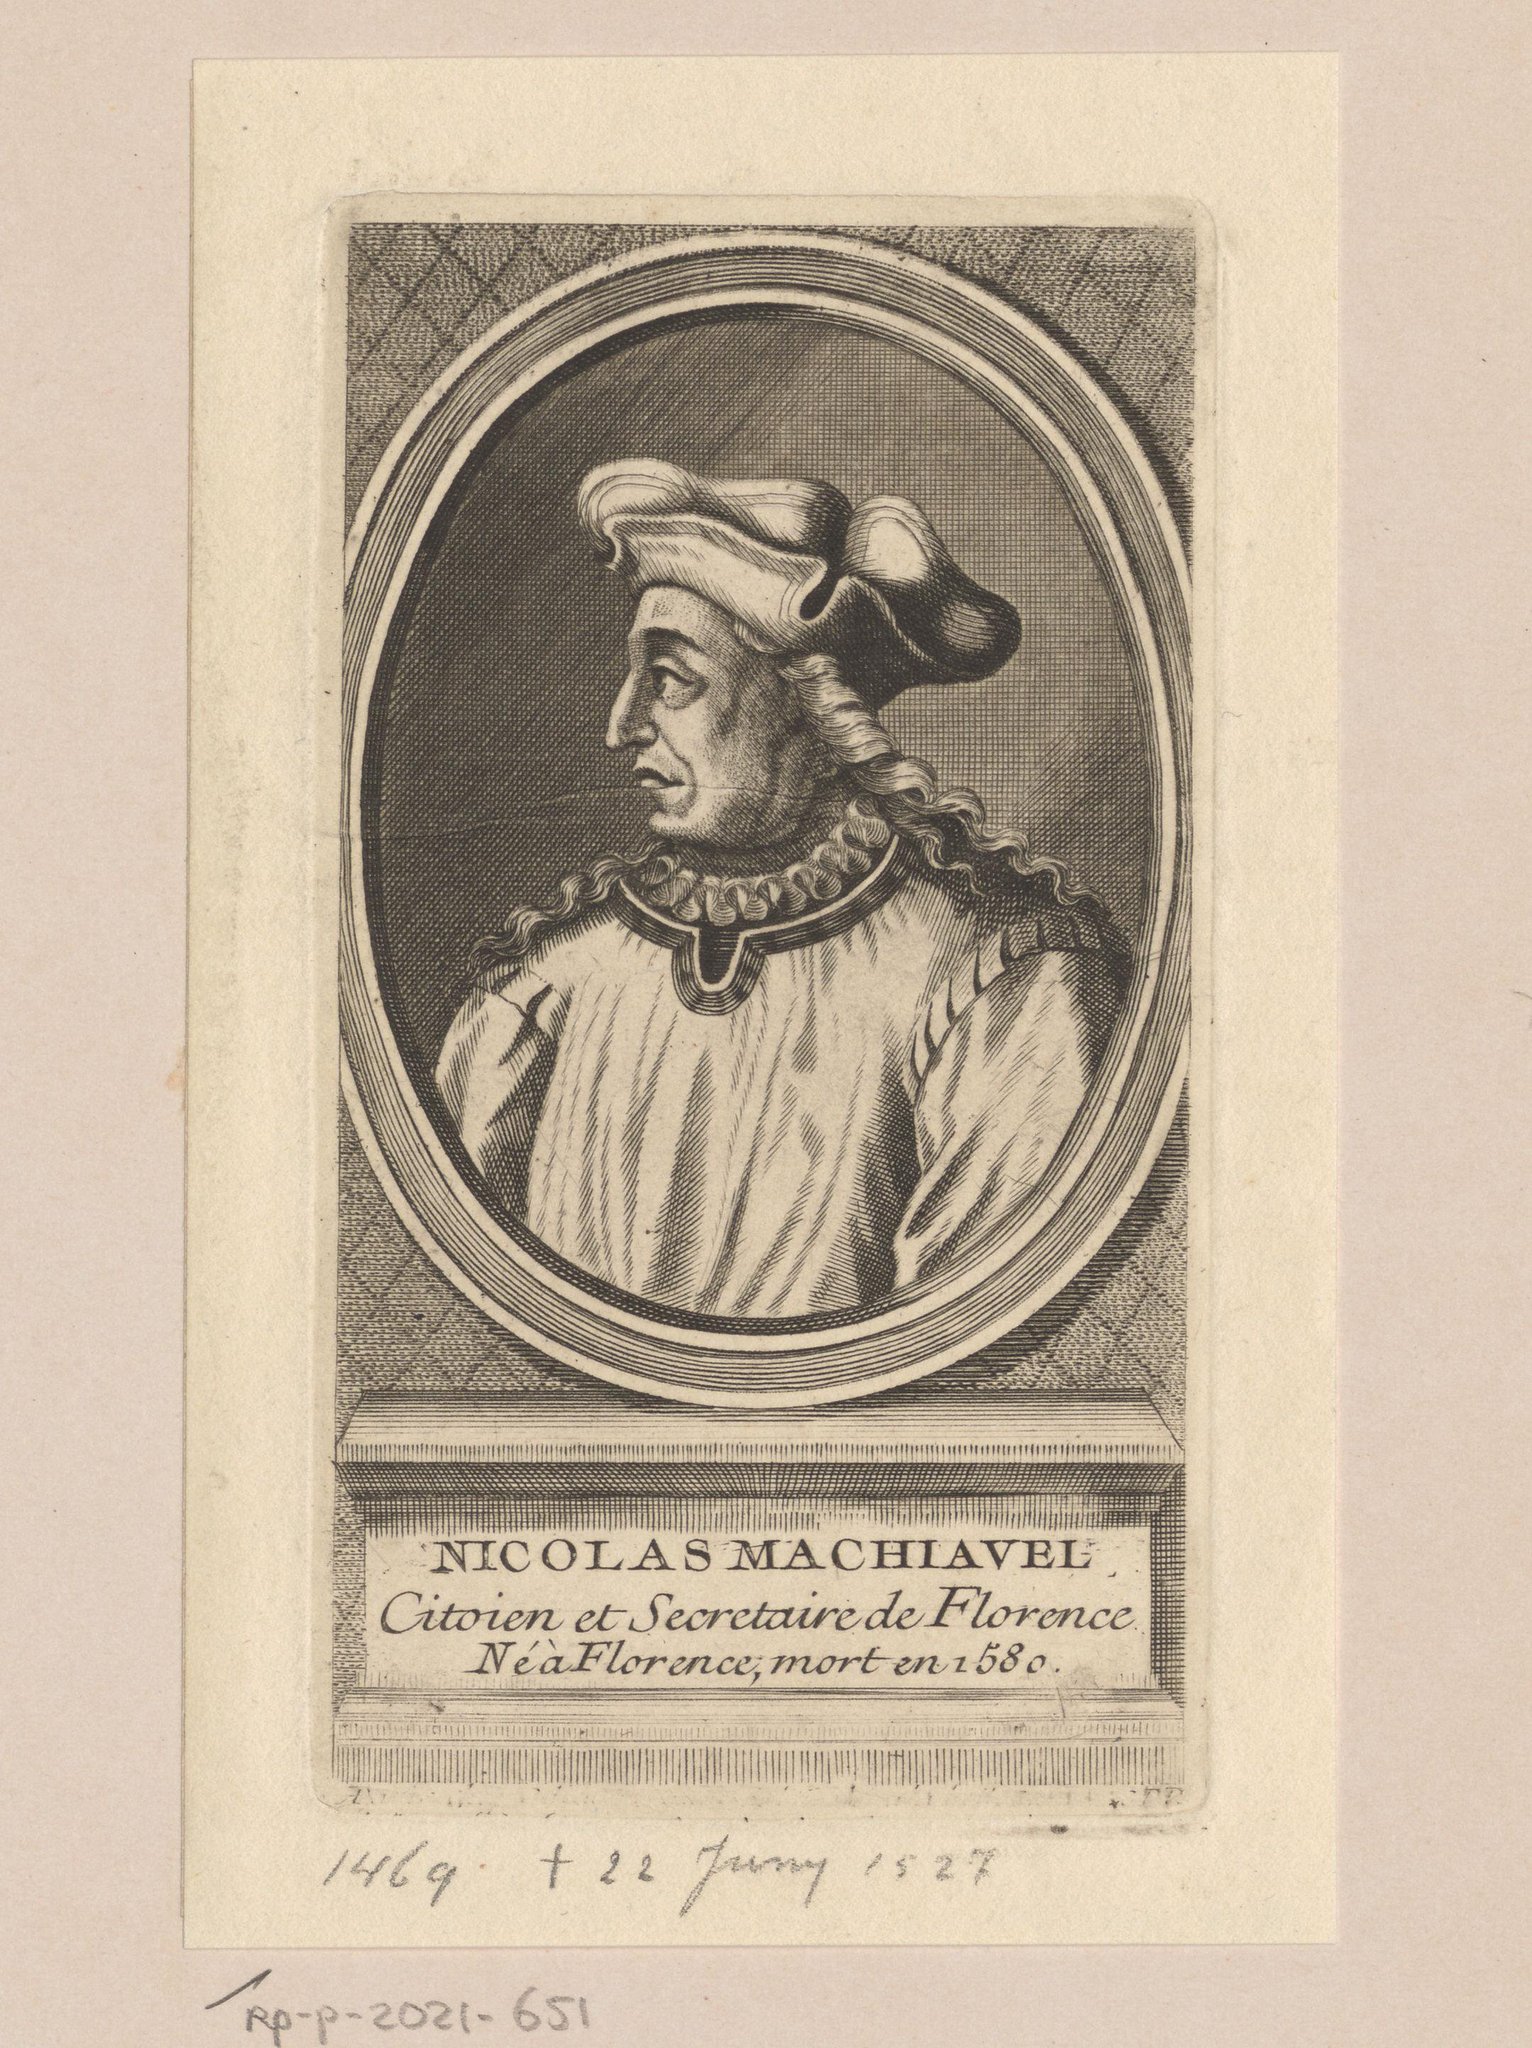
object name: print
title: Portret van Niccolò Machiavelli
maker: Anonymous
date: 1650-1750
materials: paper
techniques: engraving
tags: historical persons, scholar, philosopher (+ portrait of scholar, scientist)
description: Prent mogelijk uit: Macchiavelli, Niccolò. Le prince de Nicolas Machiavel: citoien et secretaire de Florence. Amsterdam: Henry Wetstein, 1684.